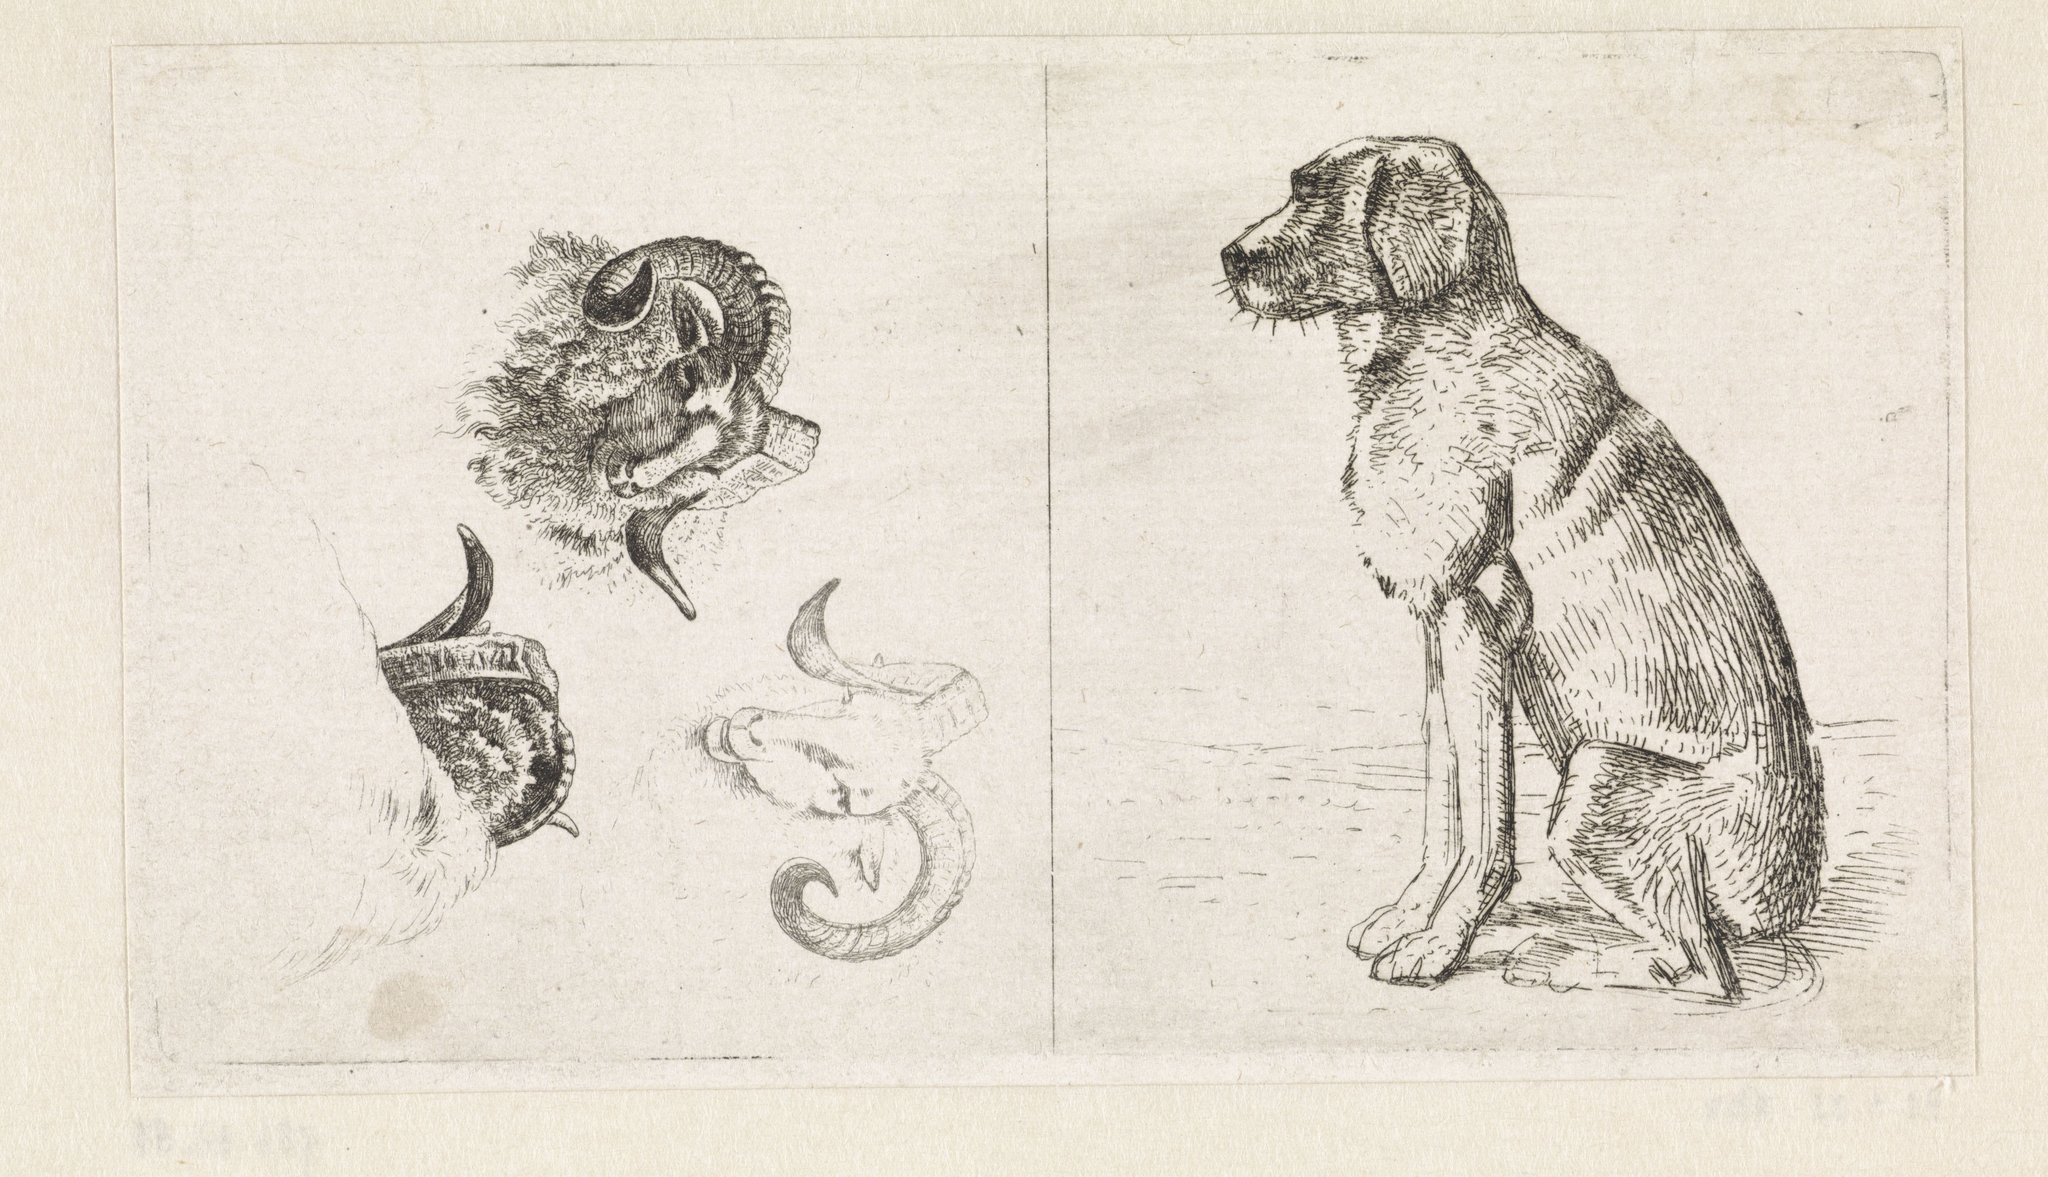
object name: print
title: Drie ramskoppen / Zittende hond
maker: wouter johannes van troostwijk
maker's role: draughtsman, painter, print maker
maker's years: 1782-1810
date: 1792-1810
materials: paper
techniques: etching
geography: amsterdam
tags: ram, dog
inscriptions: collector's mark: Lugt 2165